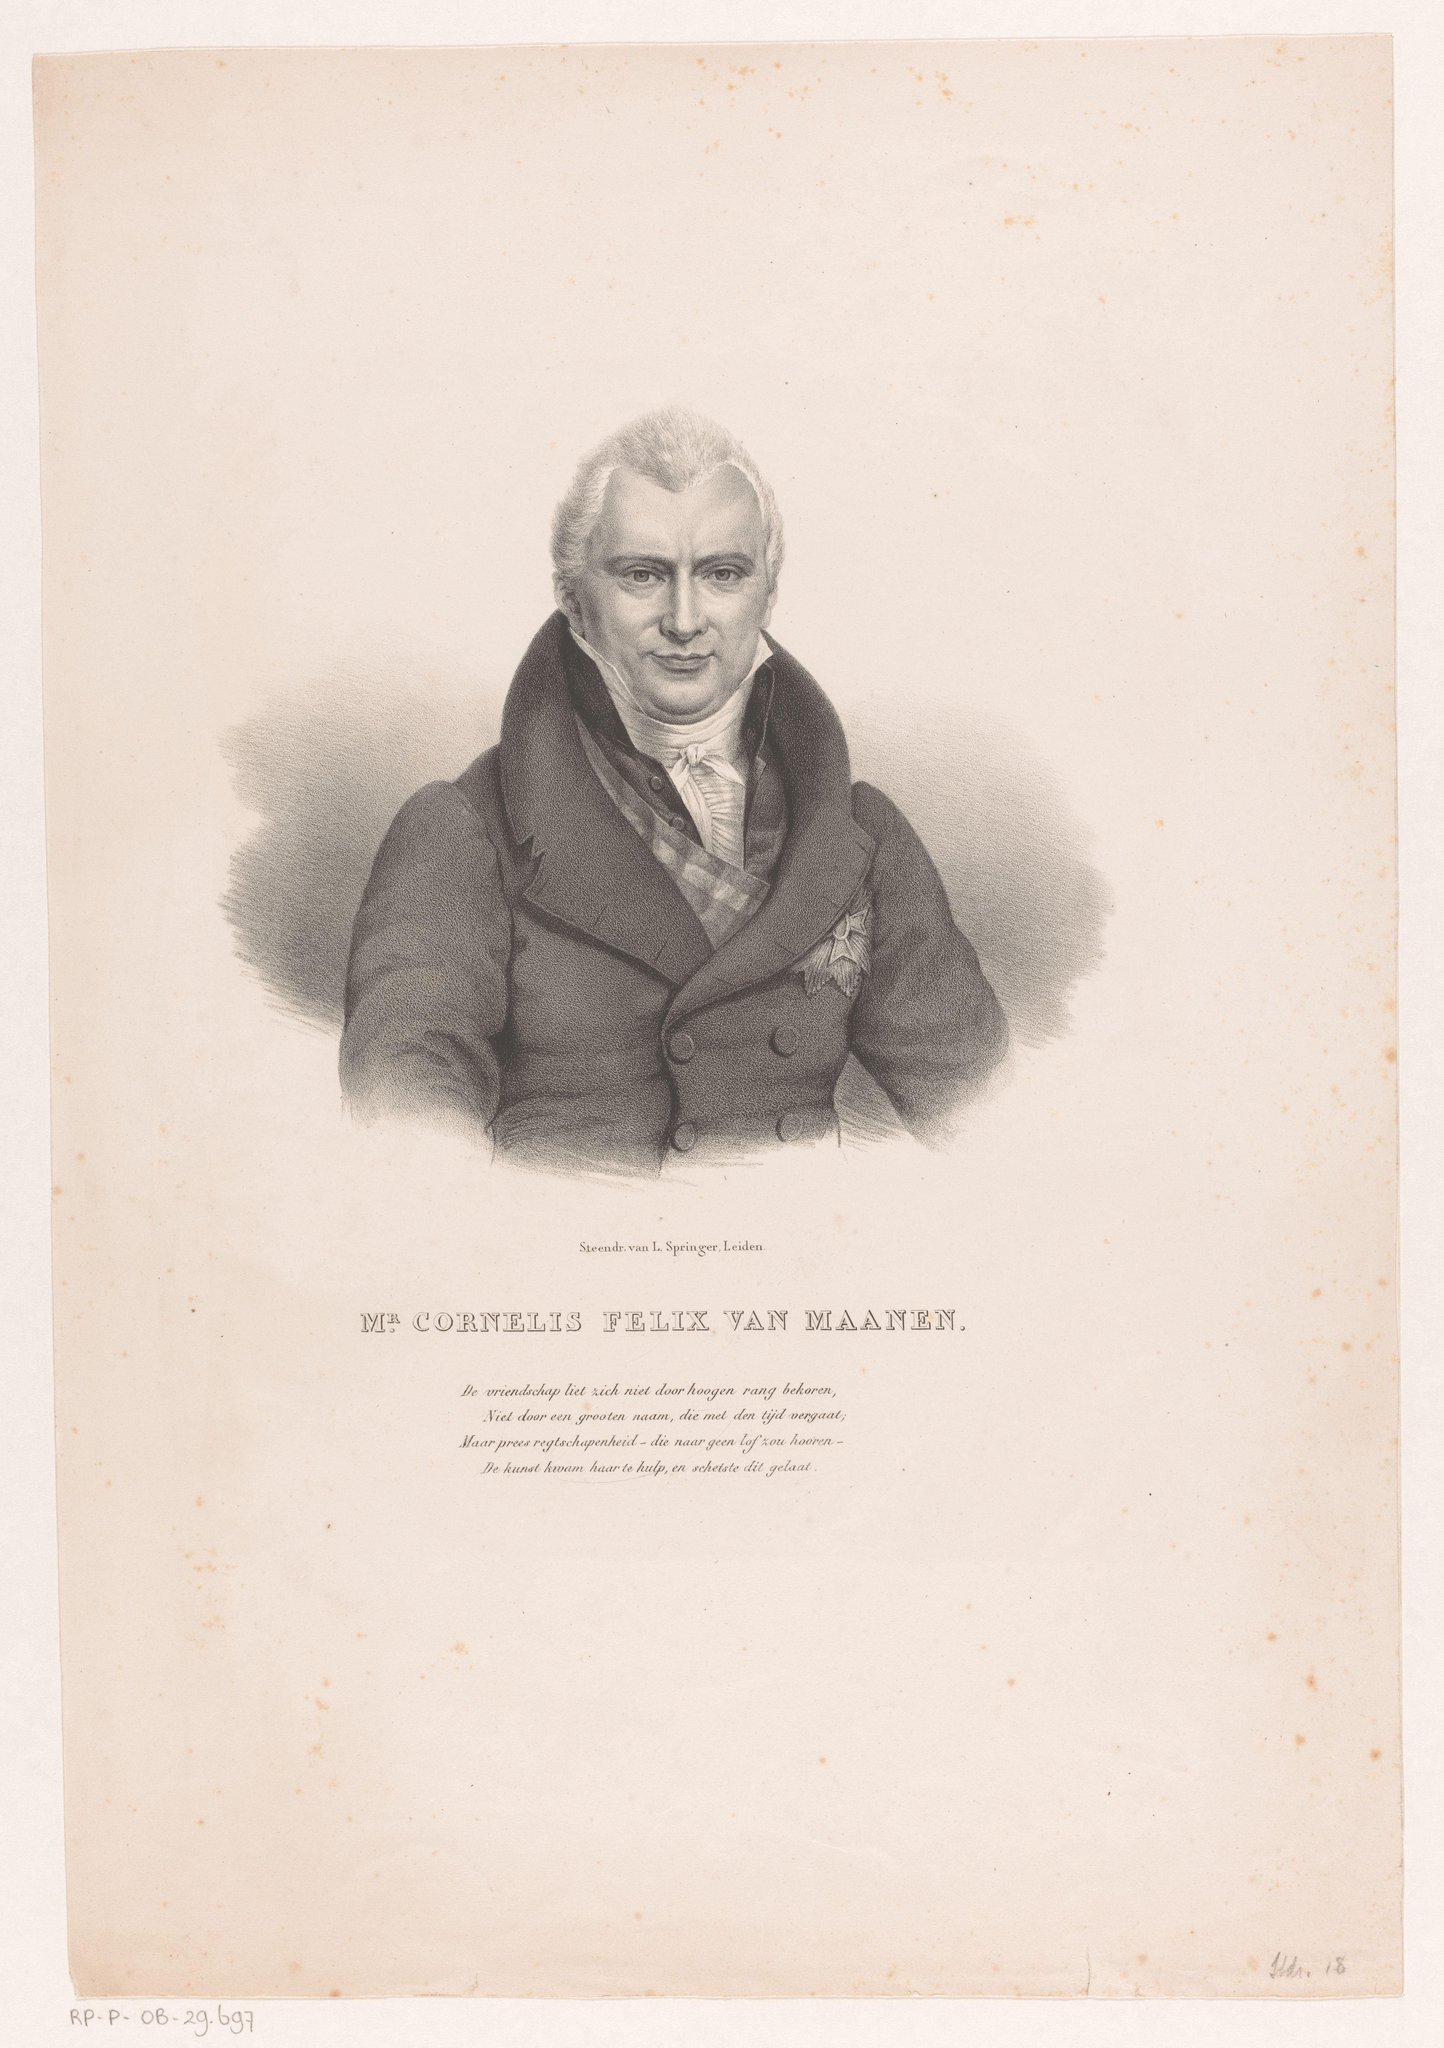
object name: print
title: Mr. Cornelis Felix van Maanen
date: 1809-1853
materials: paper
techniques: lithograph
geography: leiden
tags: historical persons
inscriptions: collector's mark: Lugt 2228